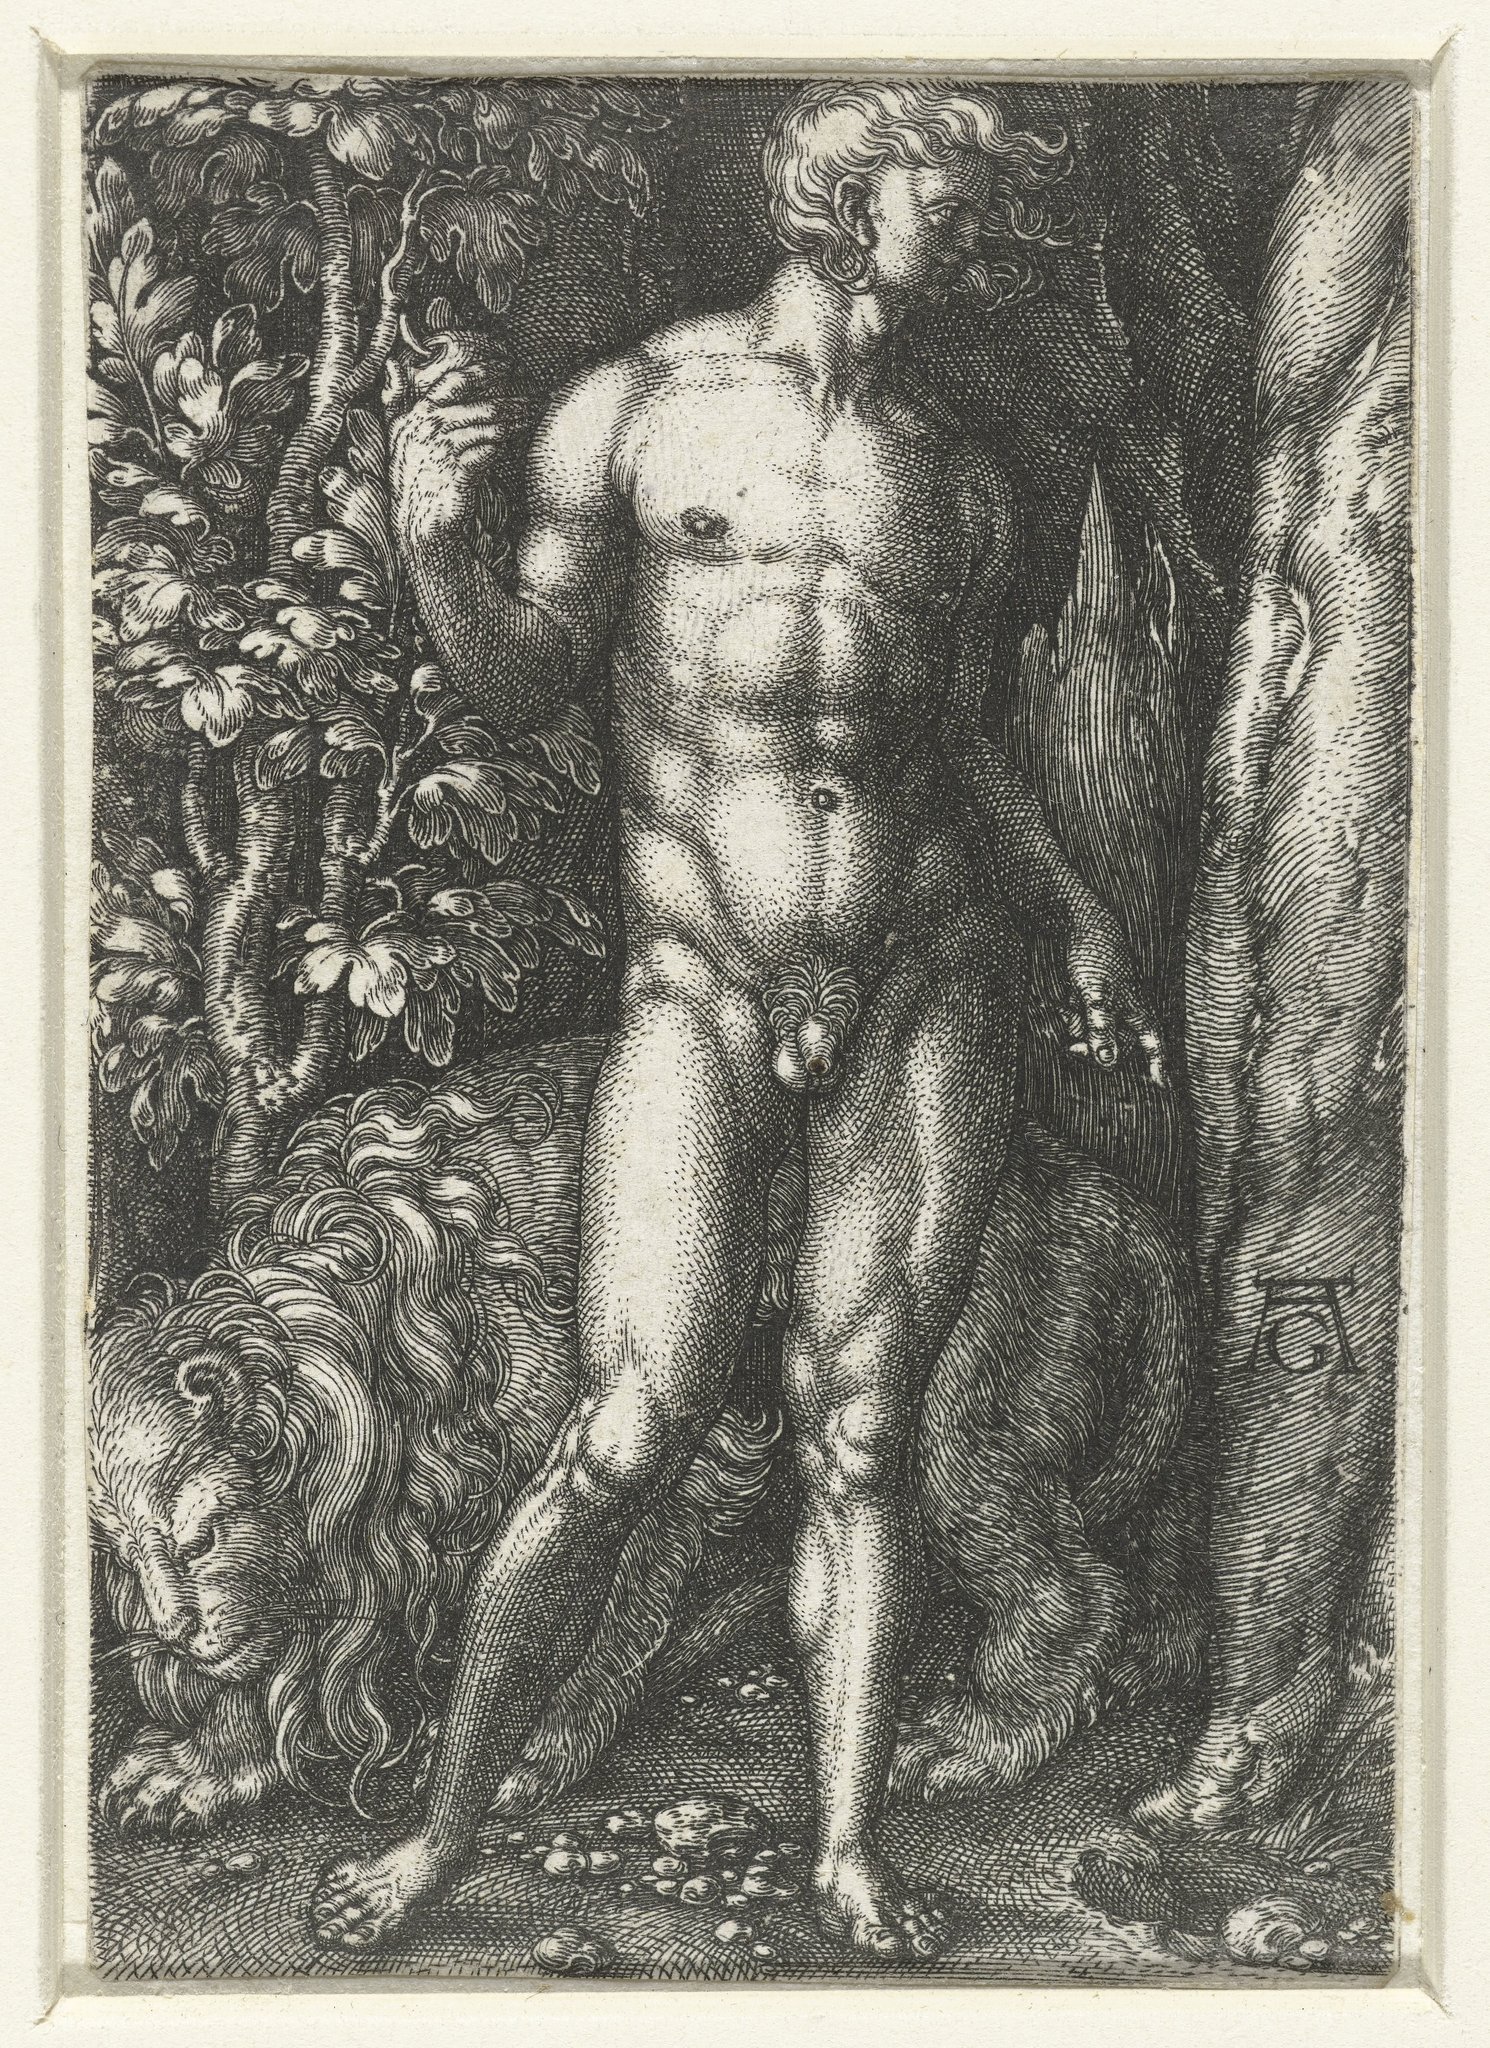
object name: print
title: Adam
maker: heinrich aldegrever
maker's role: draughtsman, print maker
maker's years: 1502-1561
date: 1512-1560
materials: paper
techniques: engraving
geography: germany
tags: adam (alone) holding the fruit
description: Adam, van voren gezien, staand naakt in het paradijs, de verboden vrucht in zijn rechterhand. Achter hem een leeuw. Vormt samen met een prent met Eva een voorstelling van de zondeval.